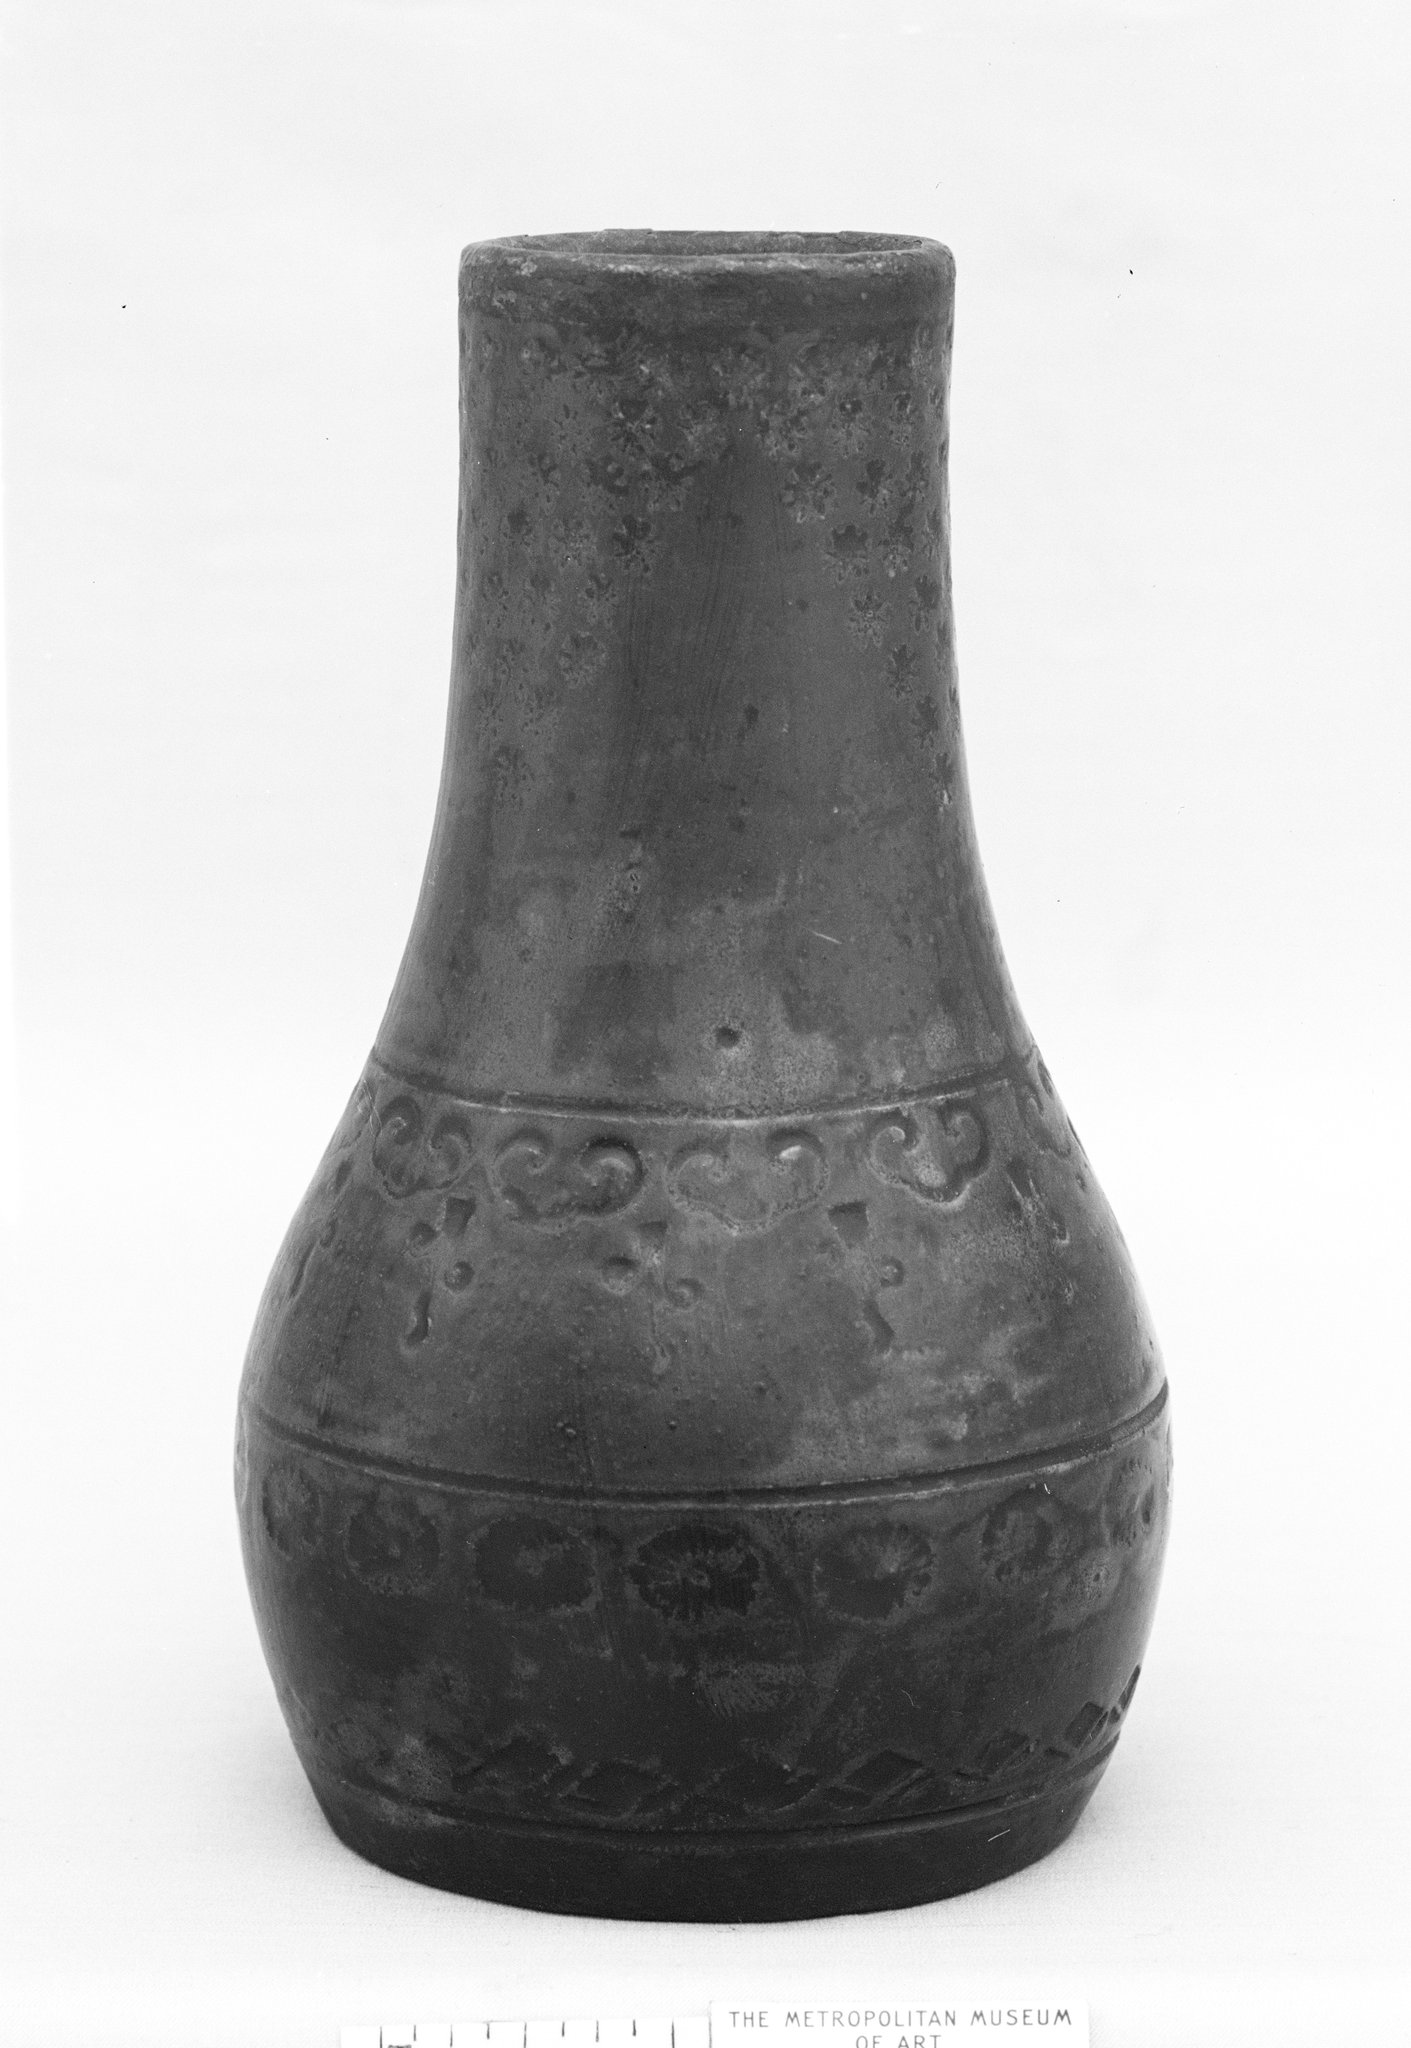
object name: vase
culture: japanese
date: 1601-1700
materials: clay, glaze